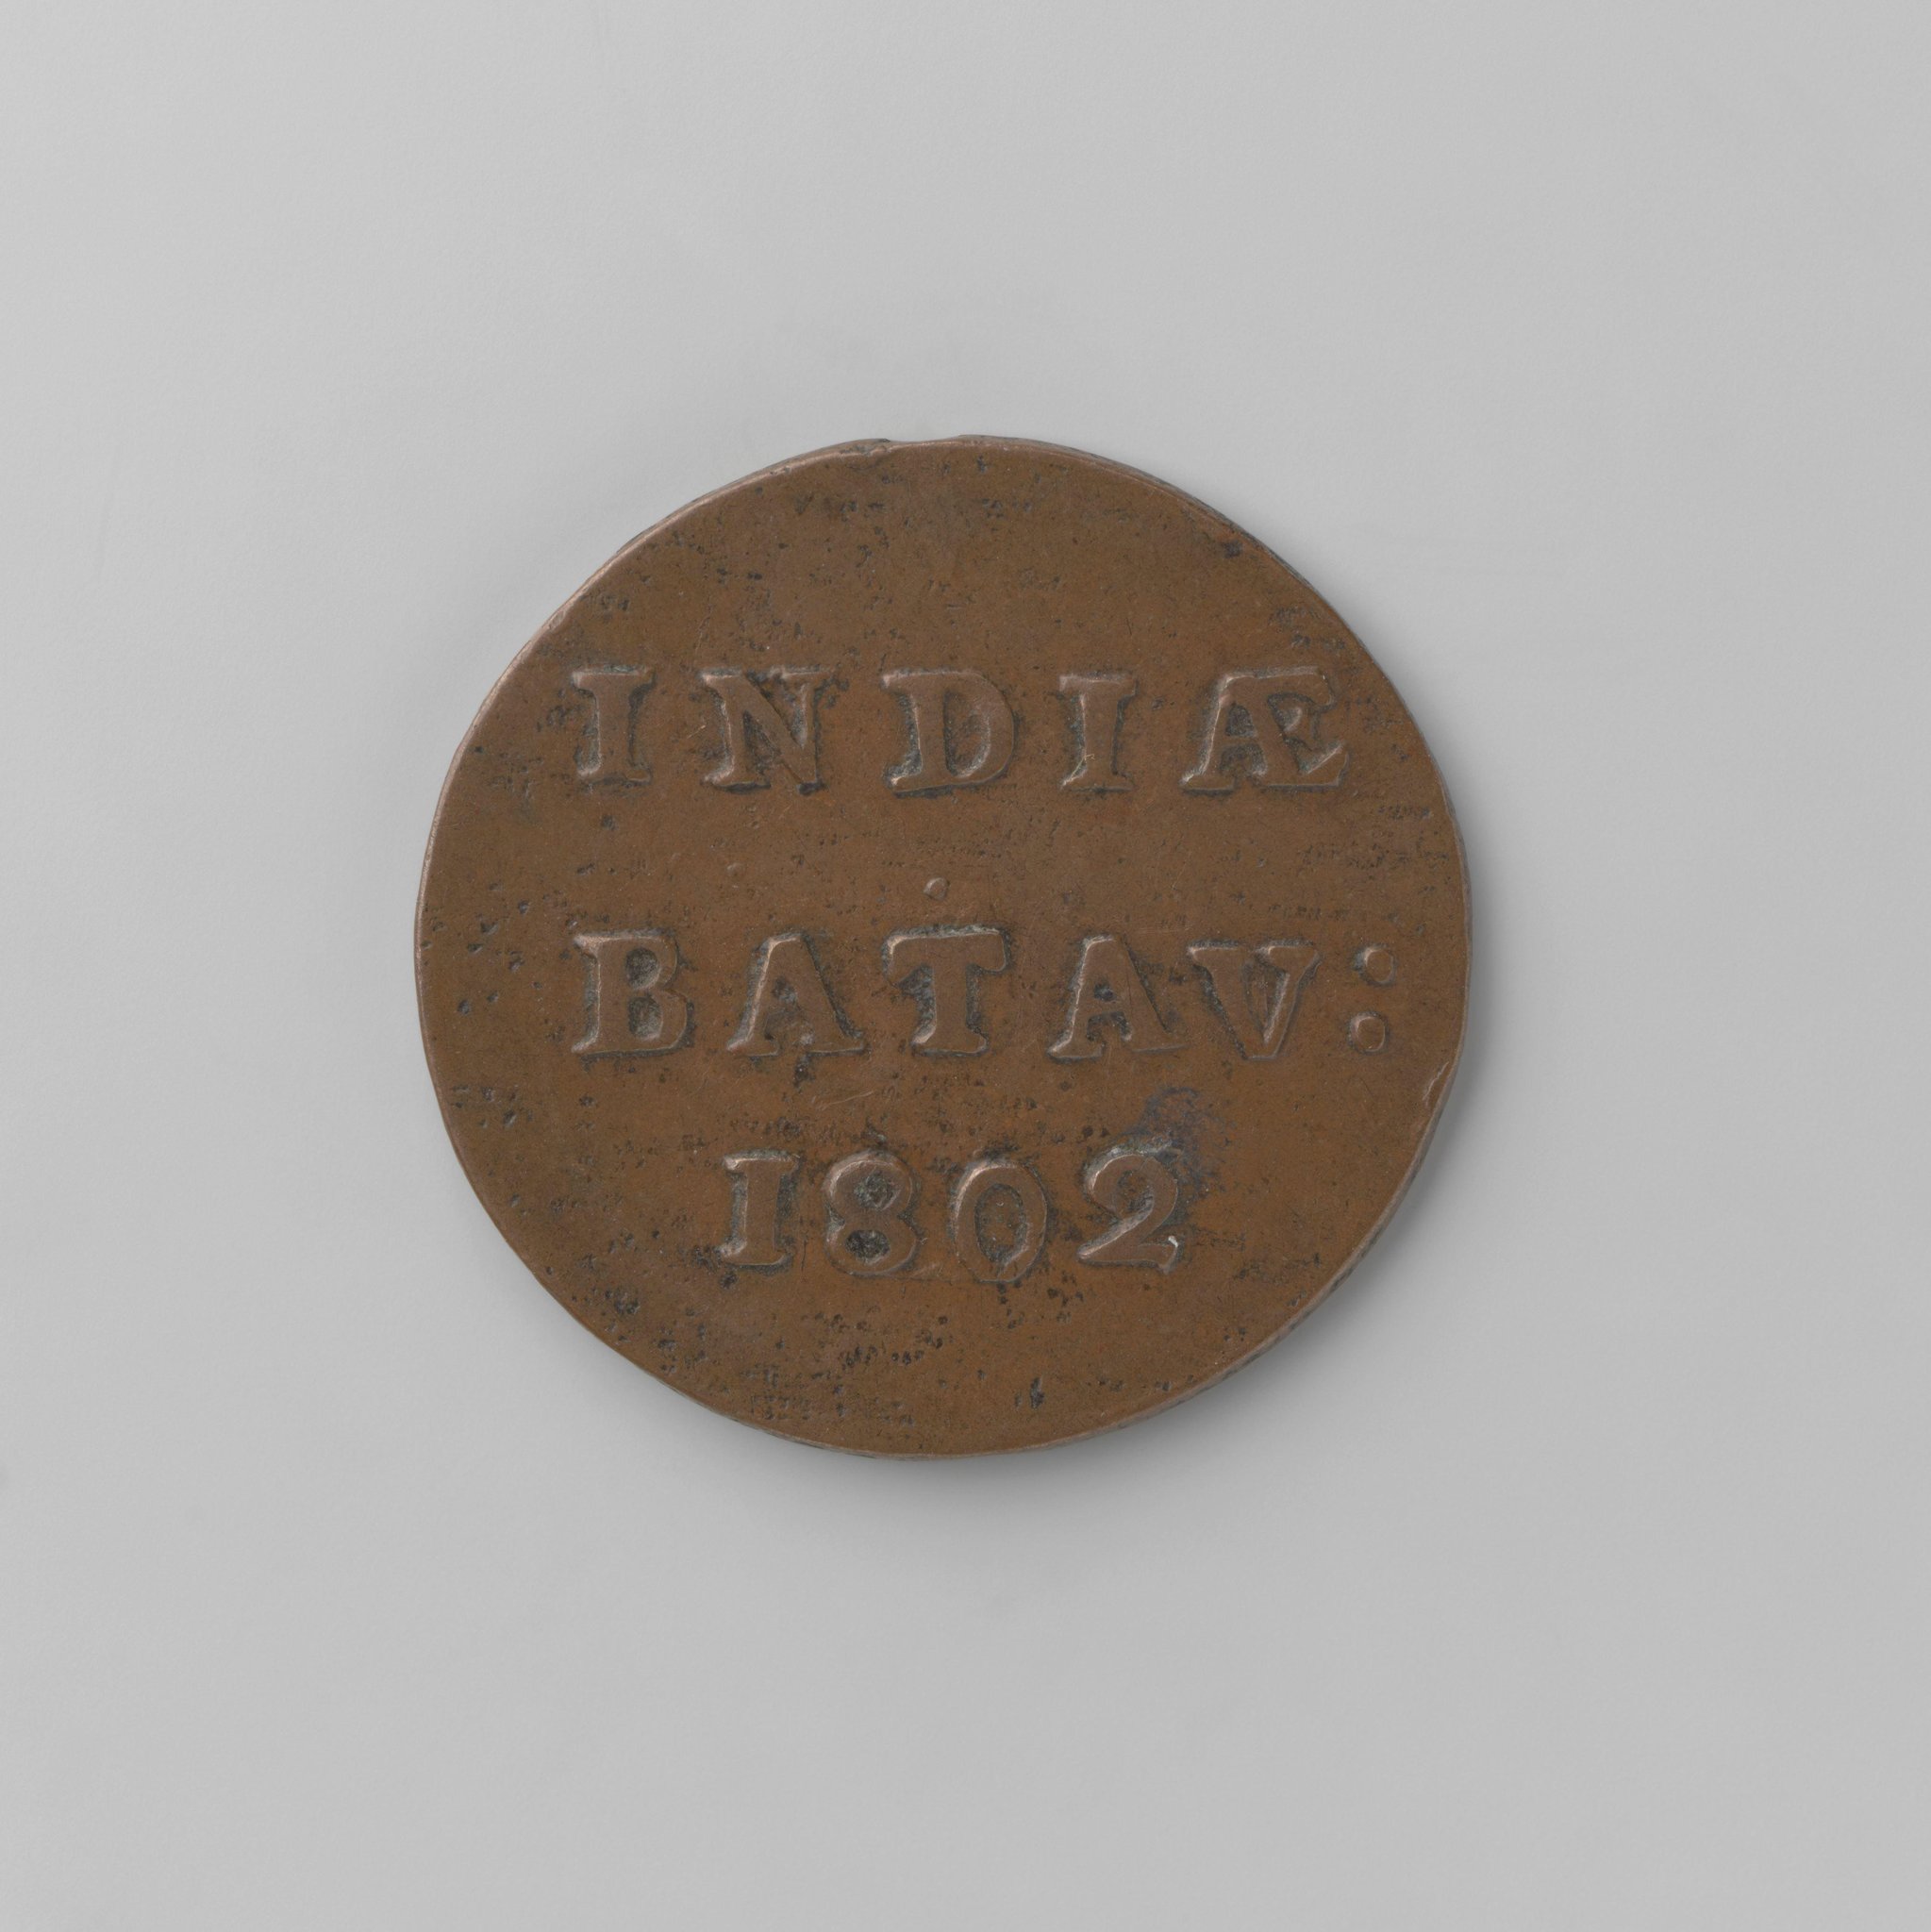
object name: coin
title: Nederlands Indië, duit Holland,1802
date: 1802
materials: copper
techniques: striking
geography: enkhuizen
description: Koperen munt. Voorzijde: tweeregelig opschrift, waarboven muntteken en waaronder jaartal. Keerzijde: tussen waarde-aanduiding 5 1/16 G gekroond generaliteitswapenschild. Gladde rand.